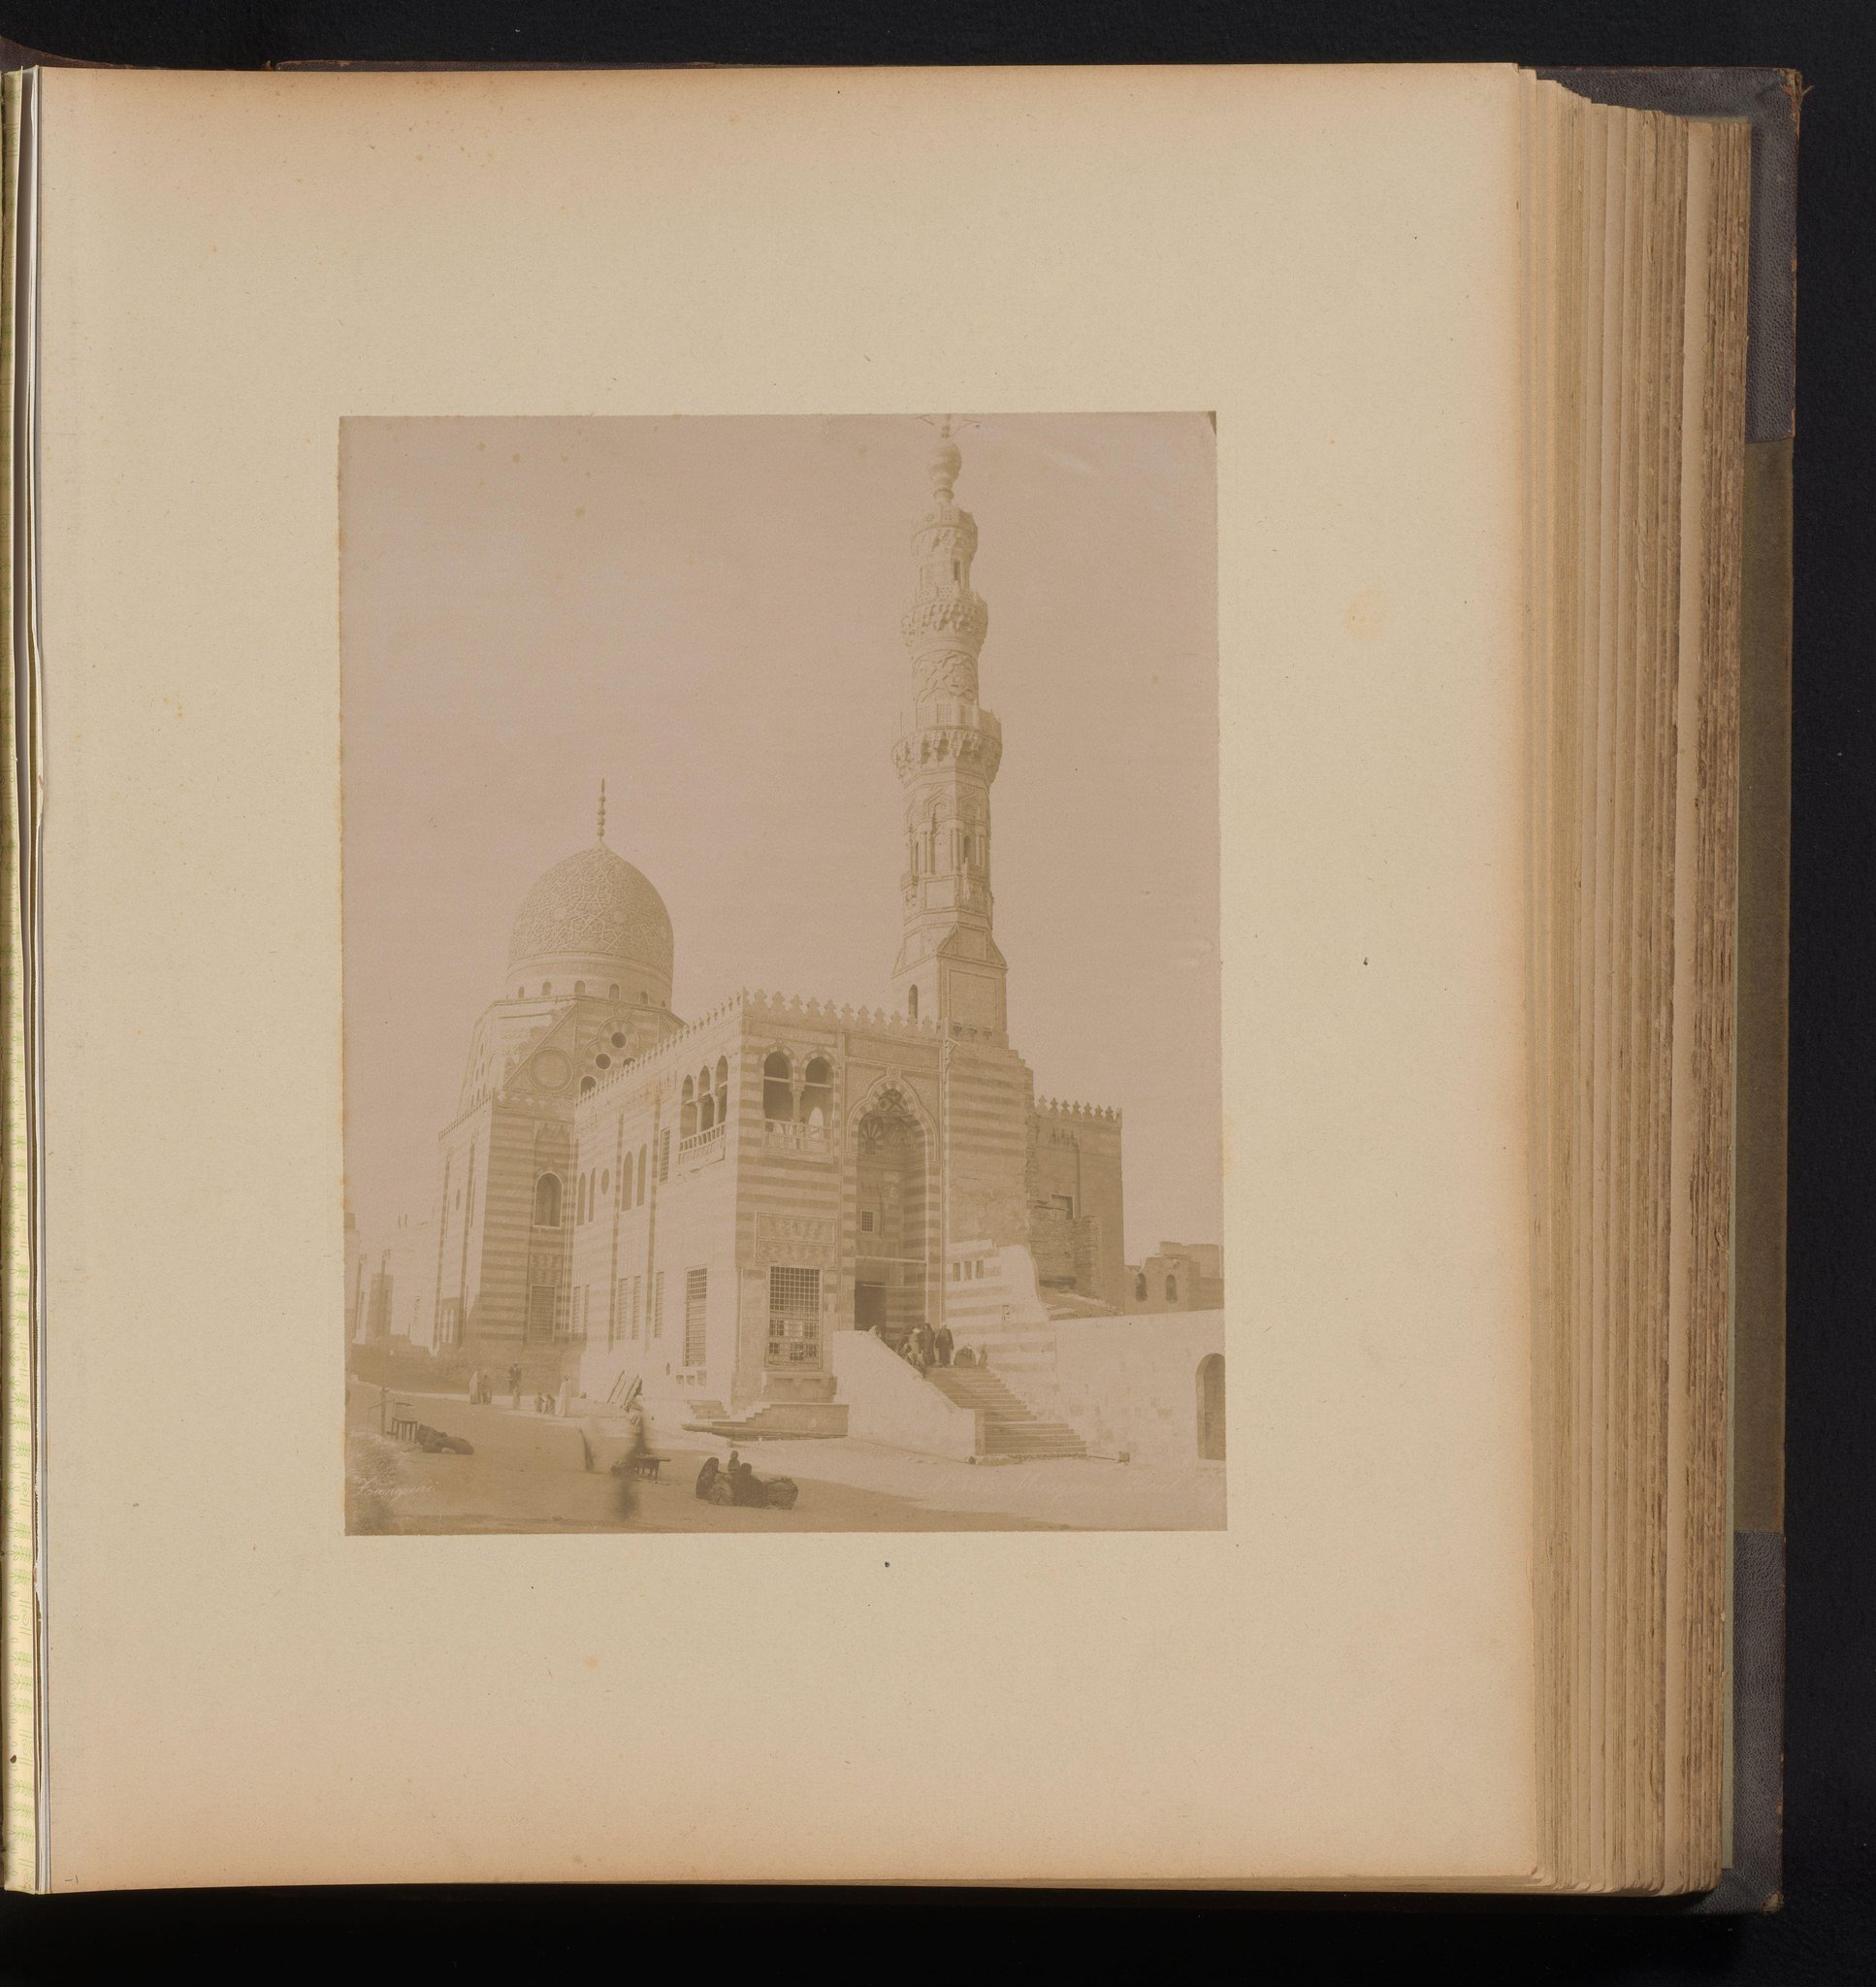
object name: album leaf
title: Mosquee Kahil bey [?]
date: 1870-1910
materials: paper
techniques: albumen print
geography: cairo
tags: temple, shrine ~ islam, mohammedanism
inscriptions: number: ‘N. 335’